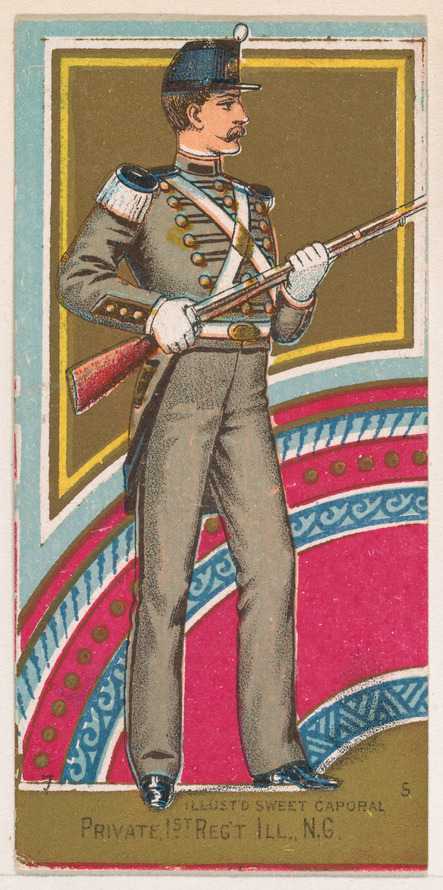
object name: print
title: Private, 1st Regiment, Illinois, National Guard, from the Military Series (N224) issued by Kinney Tobacco Company to promote Sweet Caporal Cigarettes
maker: kinney brothers tobacco company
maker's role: publisher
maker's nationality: american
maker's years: 1869-2011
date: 1888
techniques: color lithograph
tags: soldiers,firearms,men,profiles